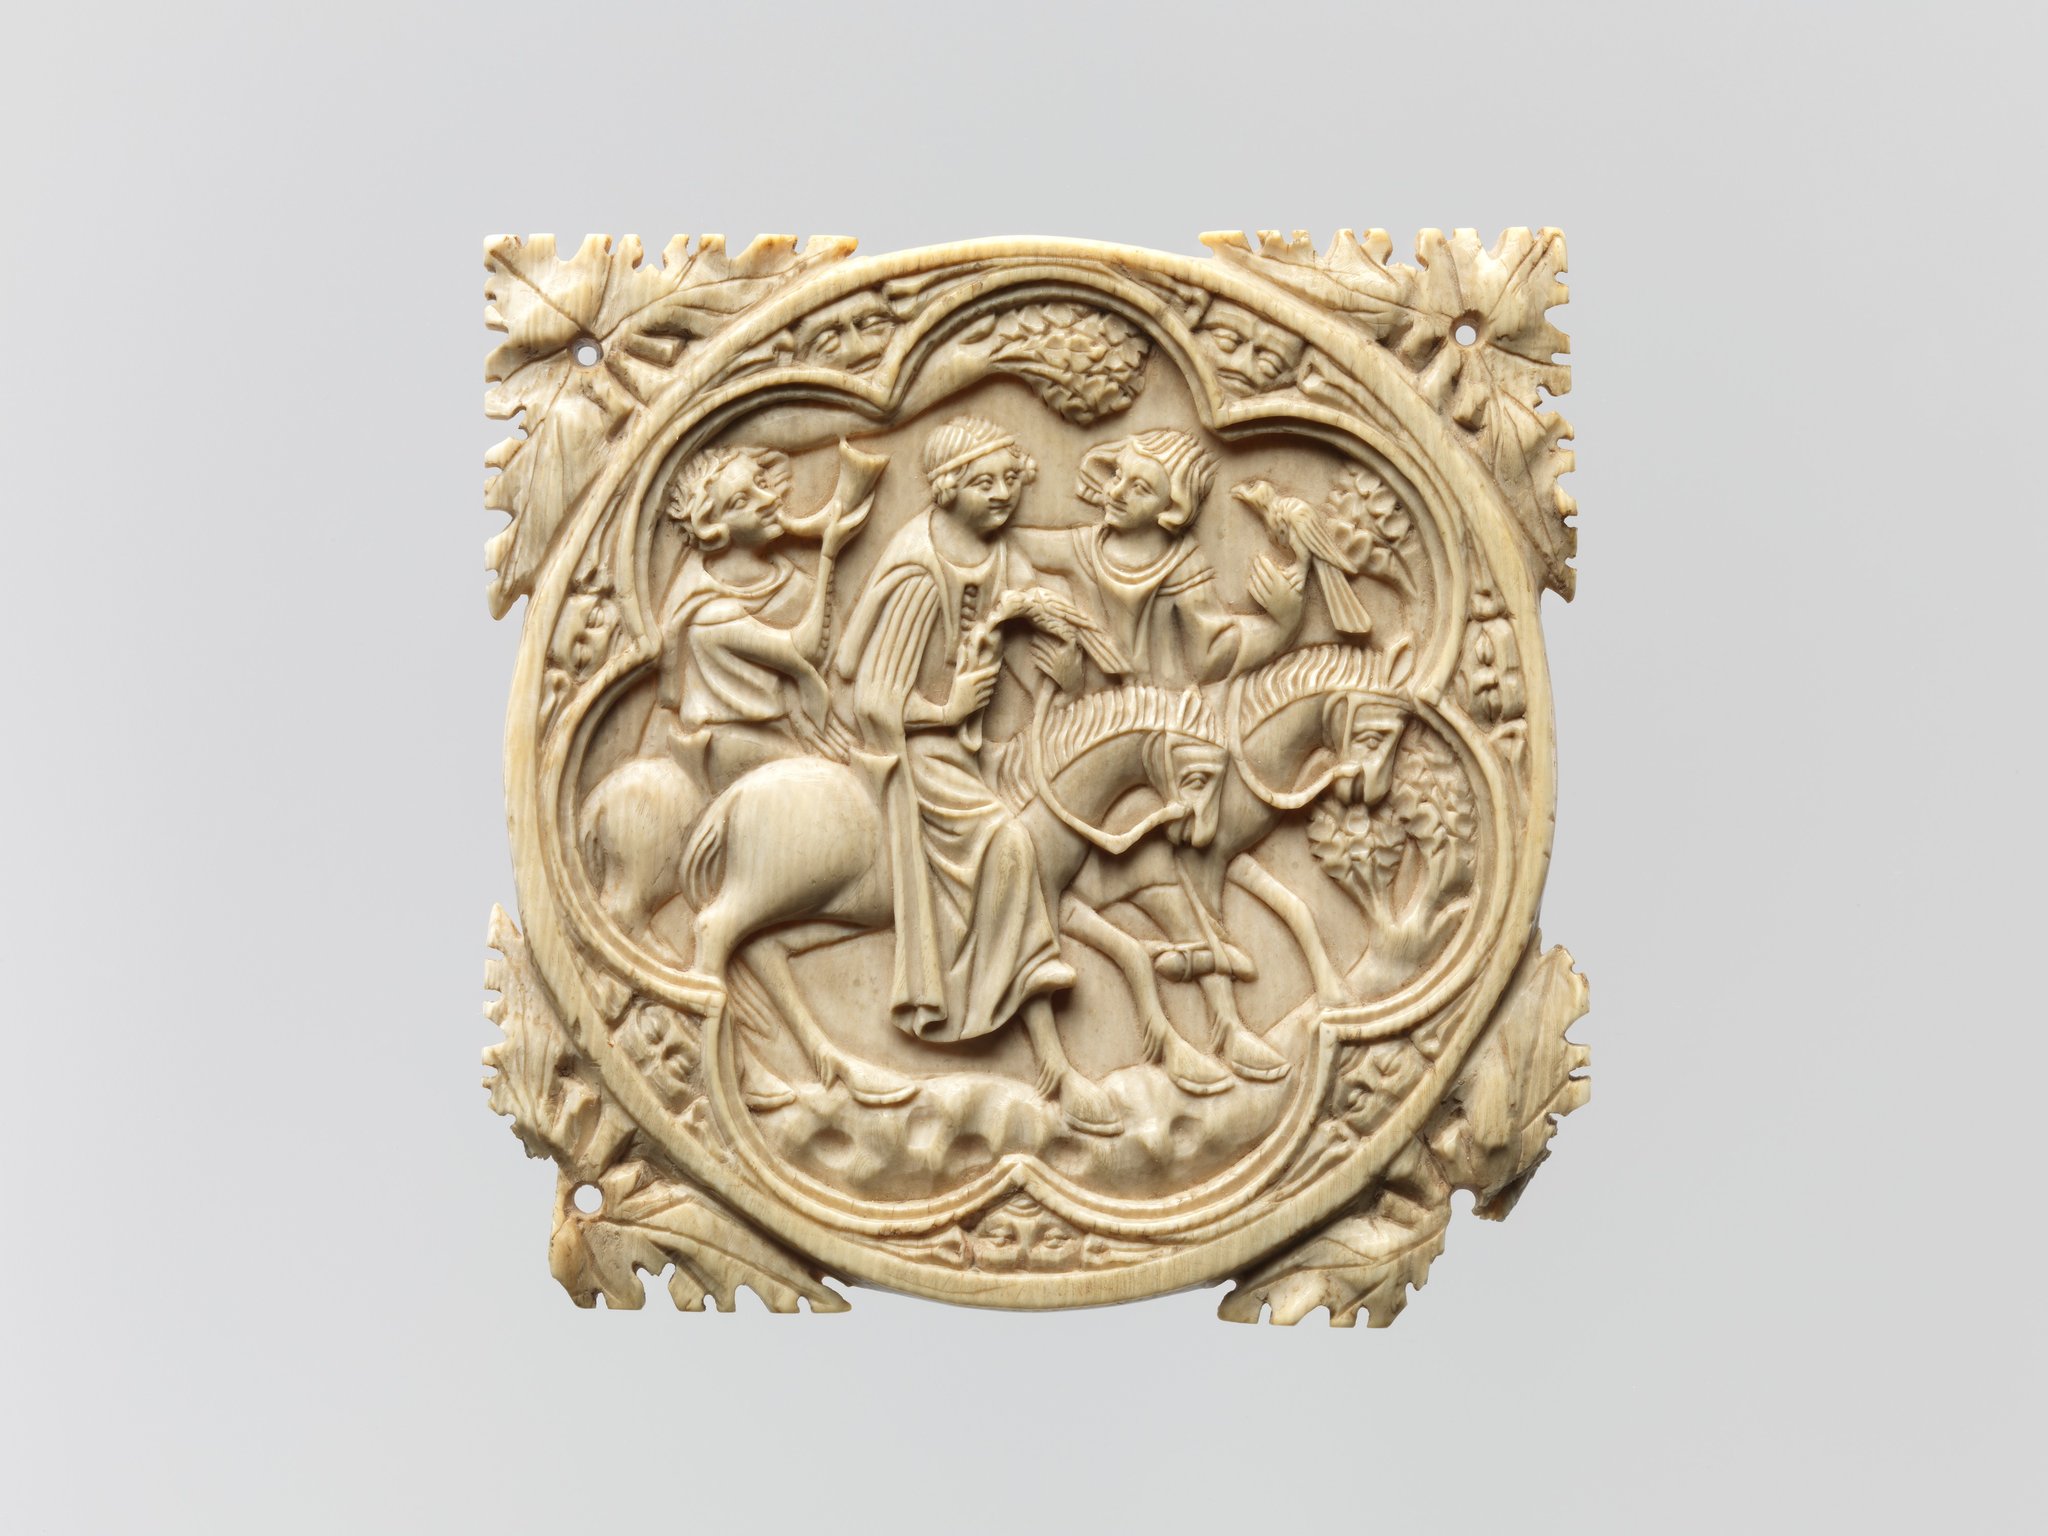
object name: mirror case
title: Ivory Mirror Case with a Falconing Party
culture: french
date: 1330-1360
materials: ivory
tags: men